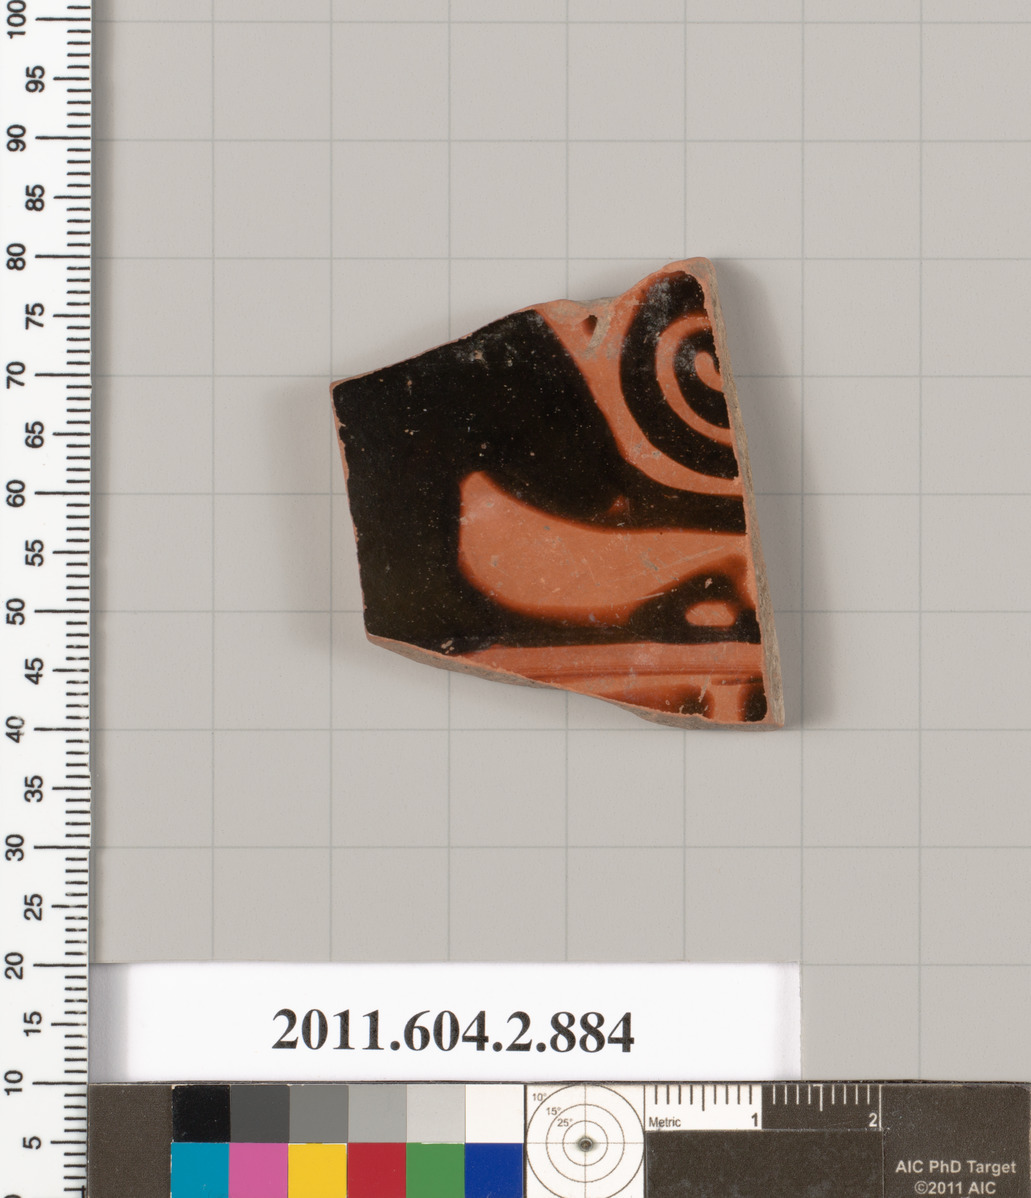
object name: bell krater fragment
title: Terracotta fragment of a bell-krater (bowl for mixing wine and water)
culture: greek, attic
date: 450-426 BCE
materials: terracotta